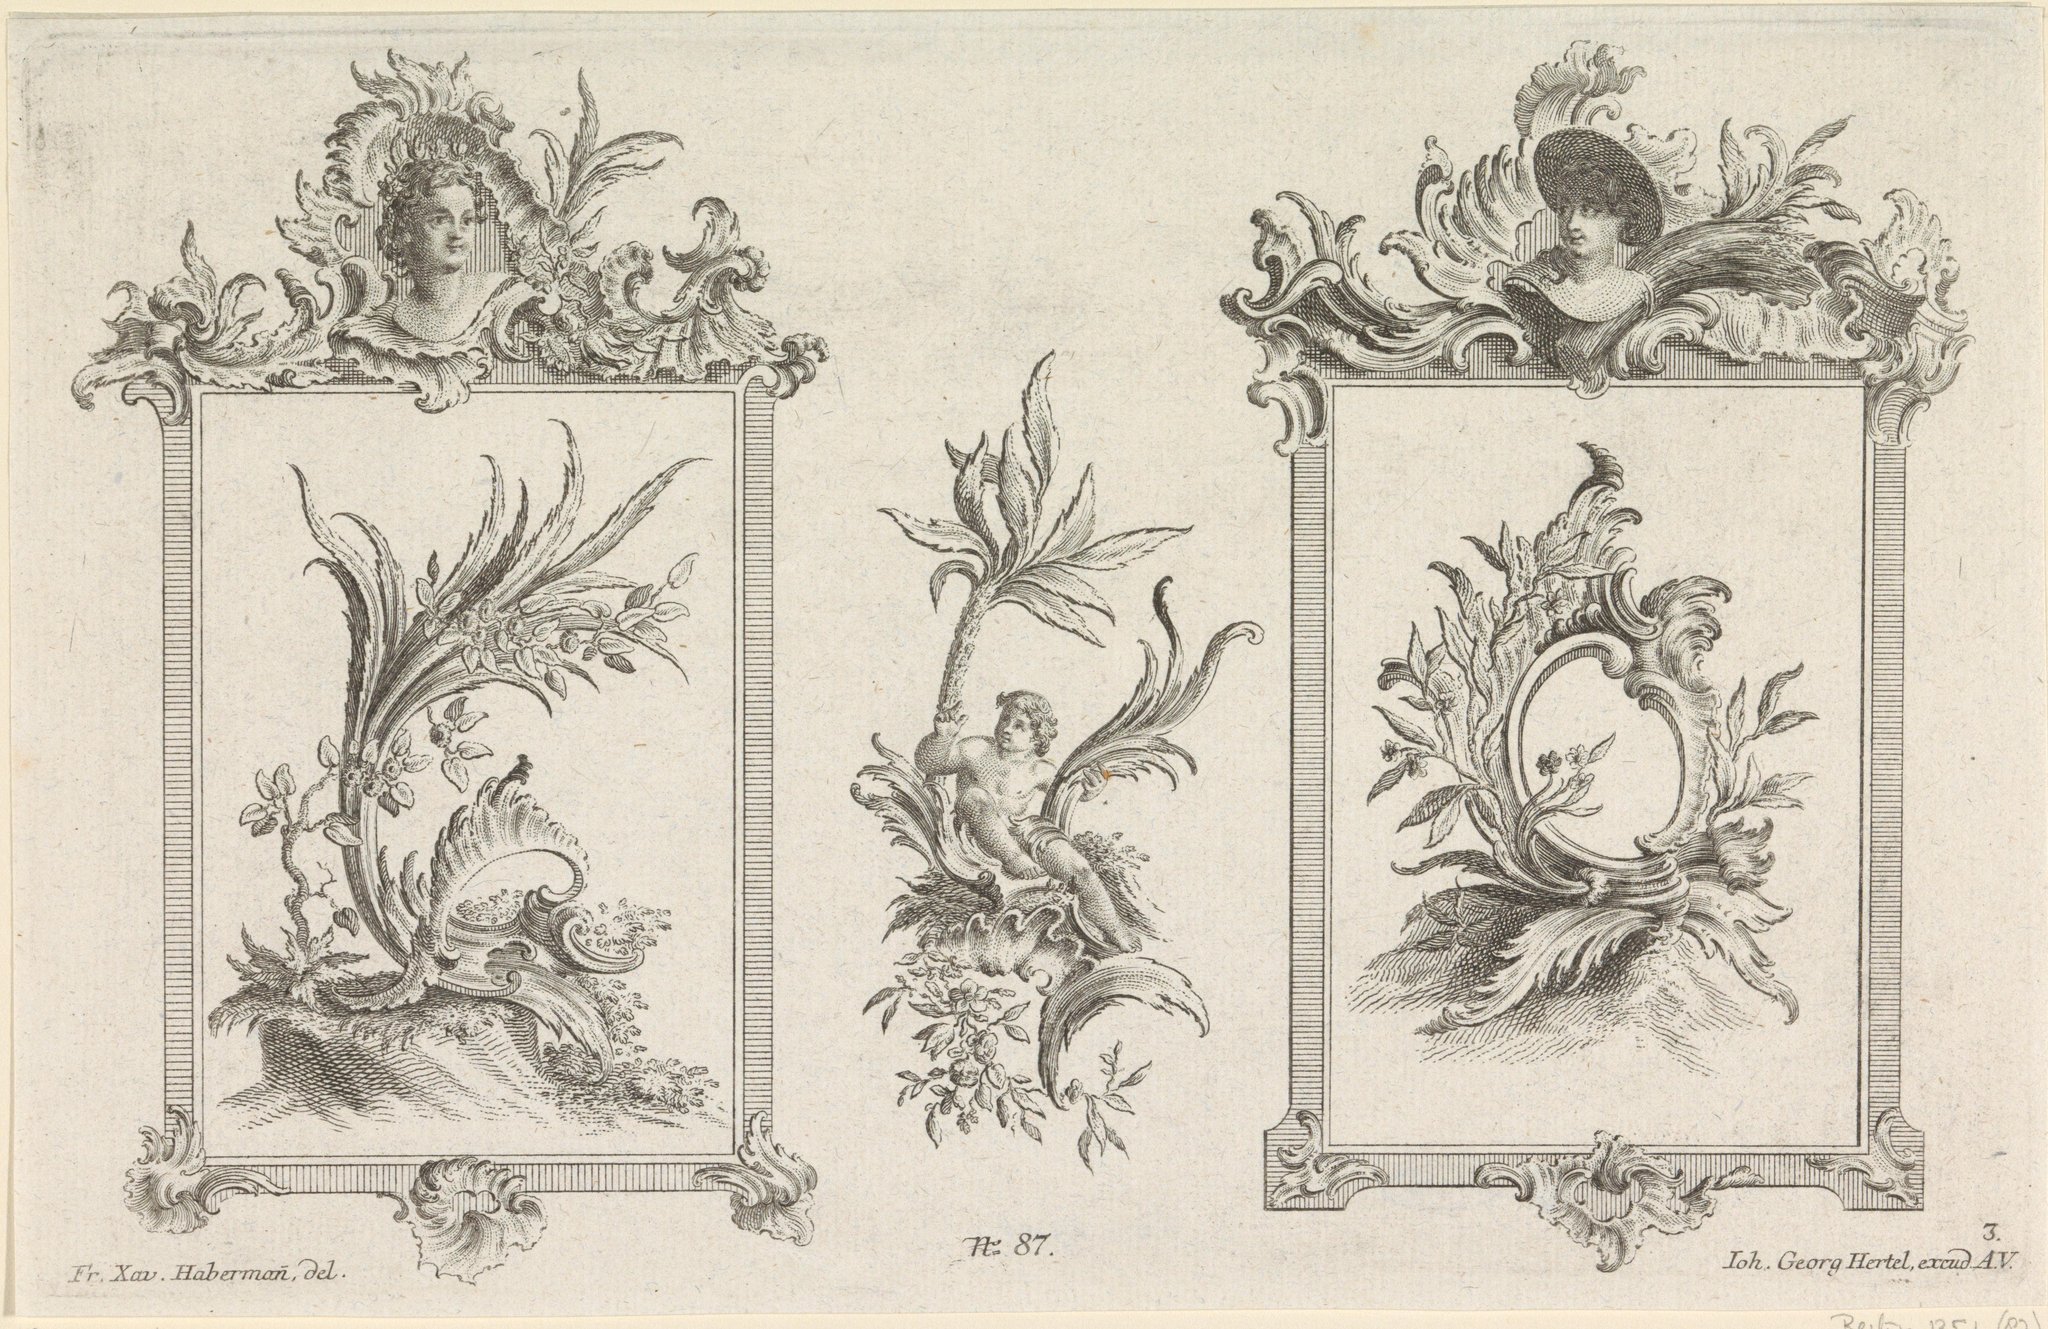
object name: ornament print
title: Ornements des Fenêtres / Fenster Außzierungen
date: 1731-1775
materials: paper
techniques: etching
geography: augsburg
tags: rocaille ornament, window, cupids: 'amores', 'amoretti', 'putti'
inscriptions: collector's mark: Lugt 2760, collector's mark: Lugt 2228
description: Twee rocaille vensters waarin rocaille ornamenten. Aan de bovenzijde van de vensters twee gezichten in de rocailles. In het midden een putto met een palmboom op een rocaille ornament. Uitgeversnummer 87.